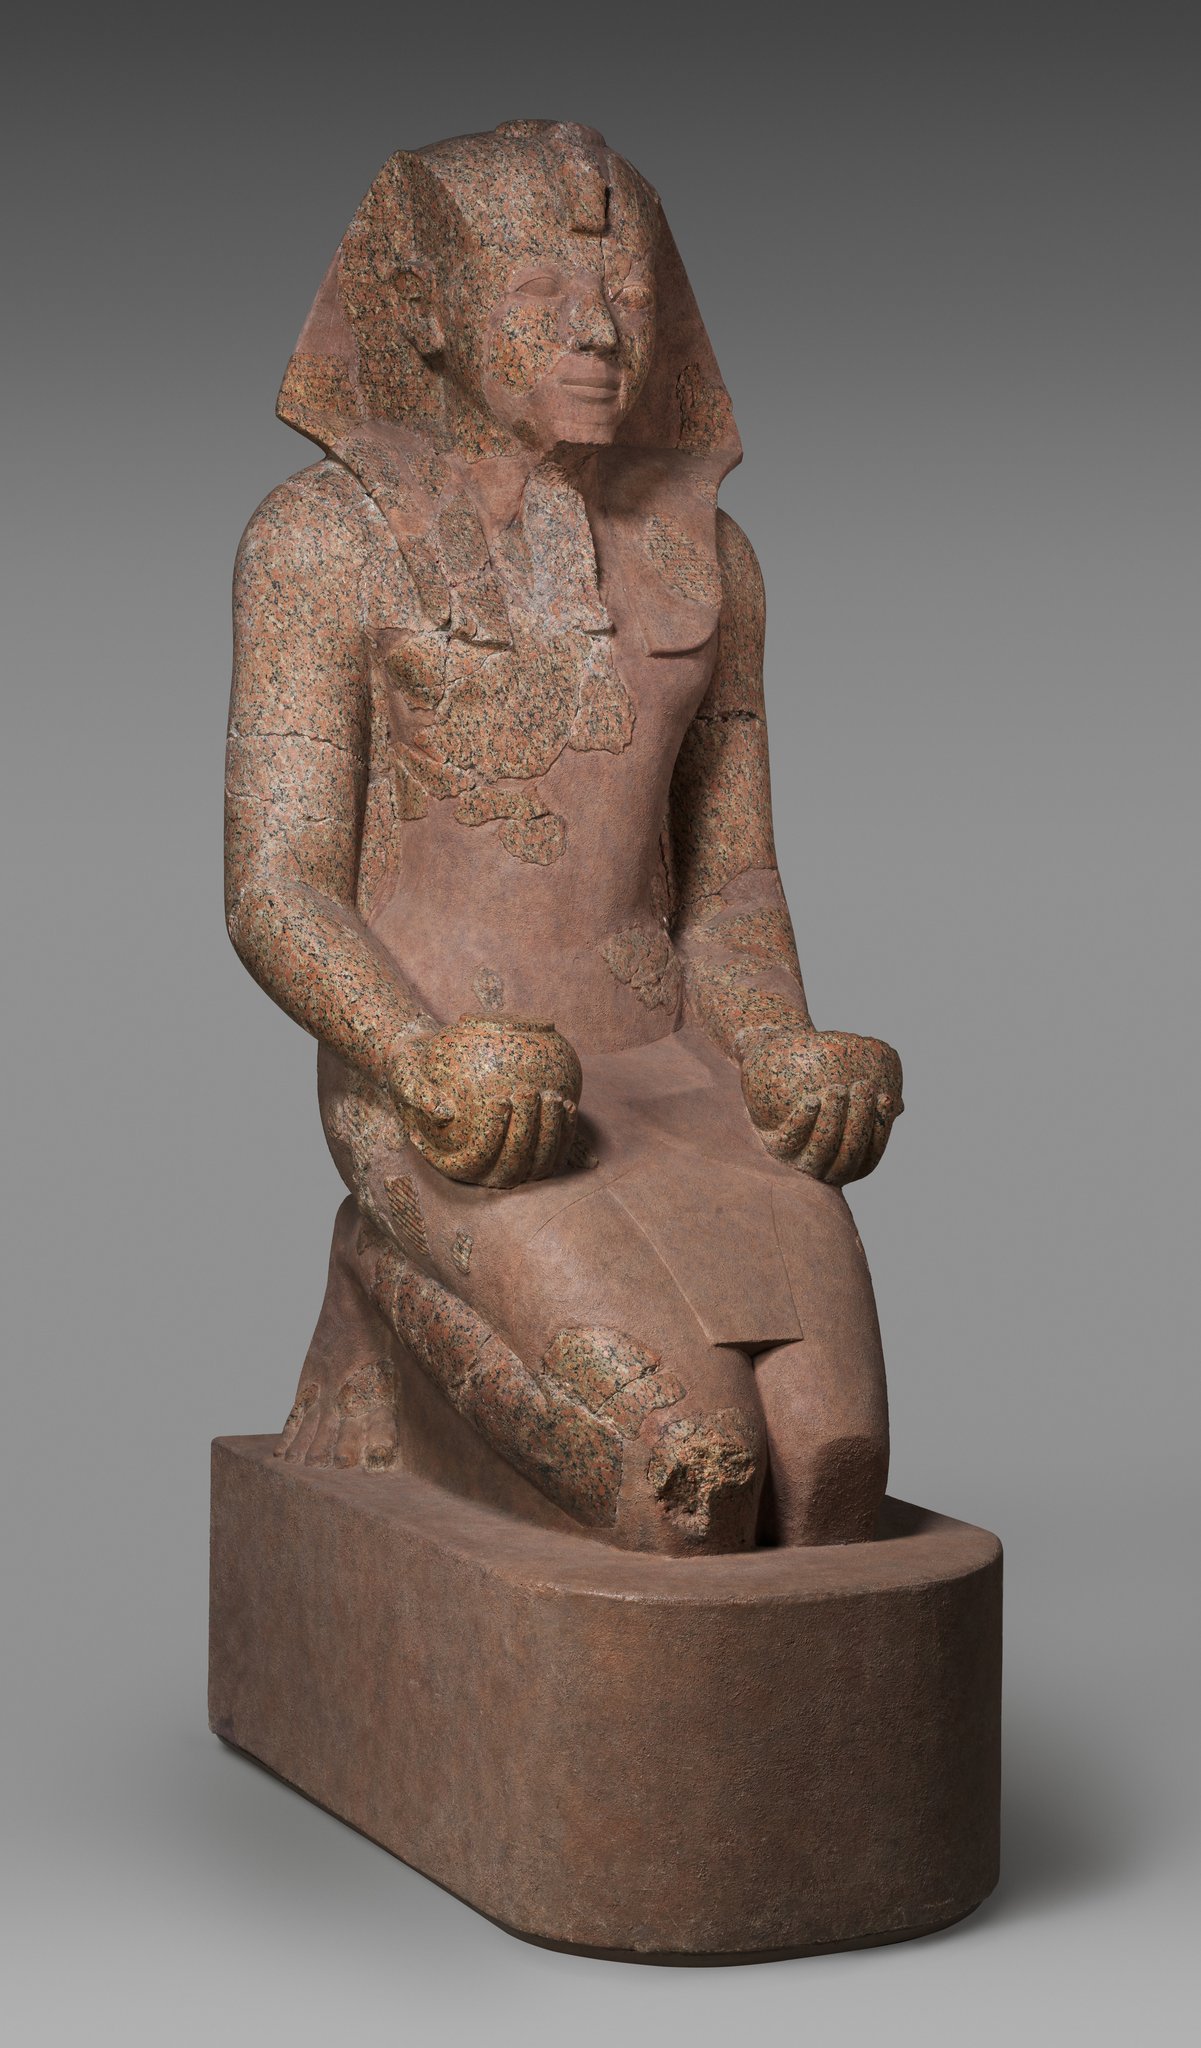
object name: statue, hatshepsut kneeling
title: Large Kneeling Statue of Hatshepsut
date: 1479-1458 BCE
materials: granite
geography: egypt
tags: kings,women